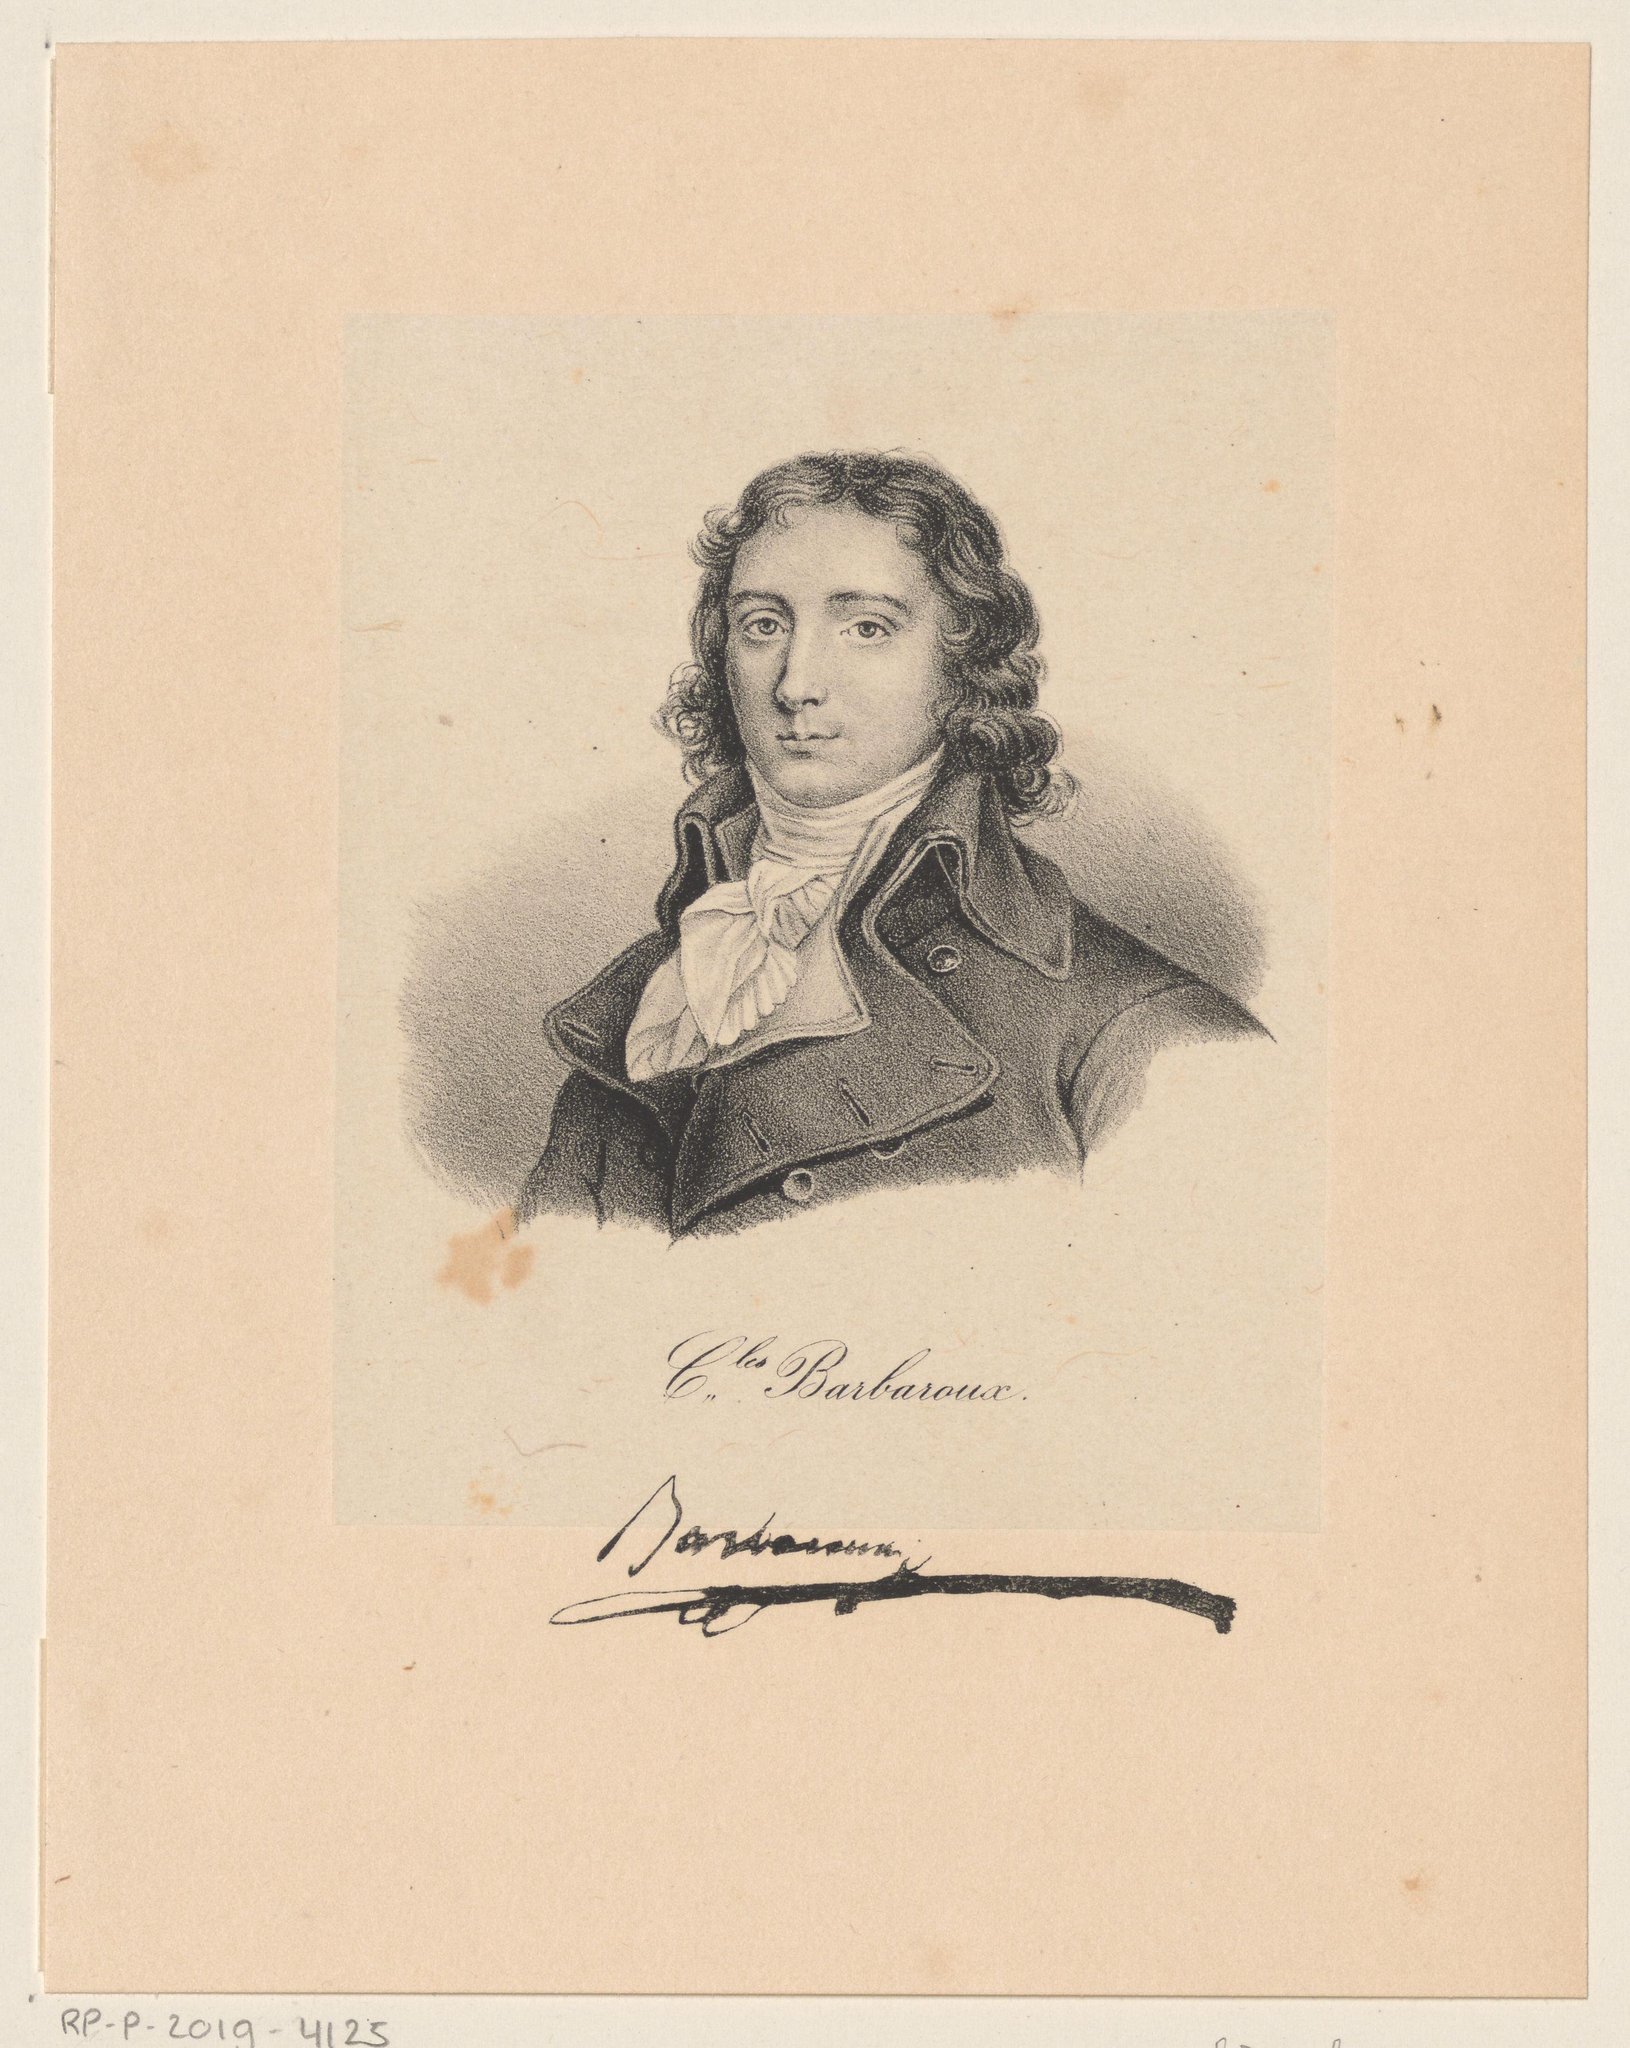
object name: print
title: Portret van Charles Barbaroux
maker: Anonymous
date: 1790-1800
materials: paper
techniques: lithograph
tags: historical persons